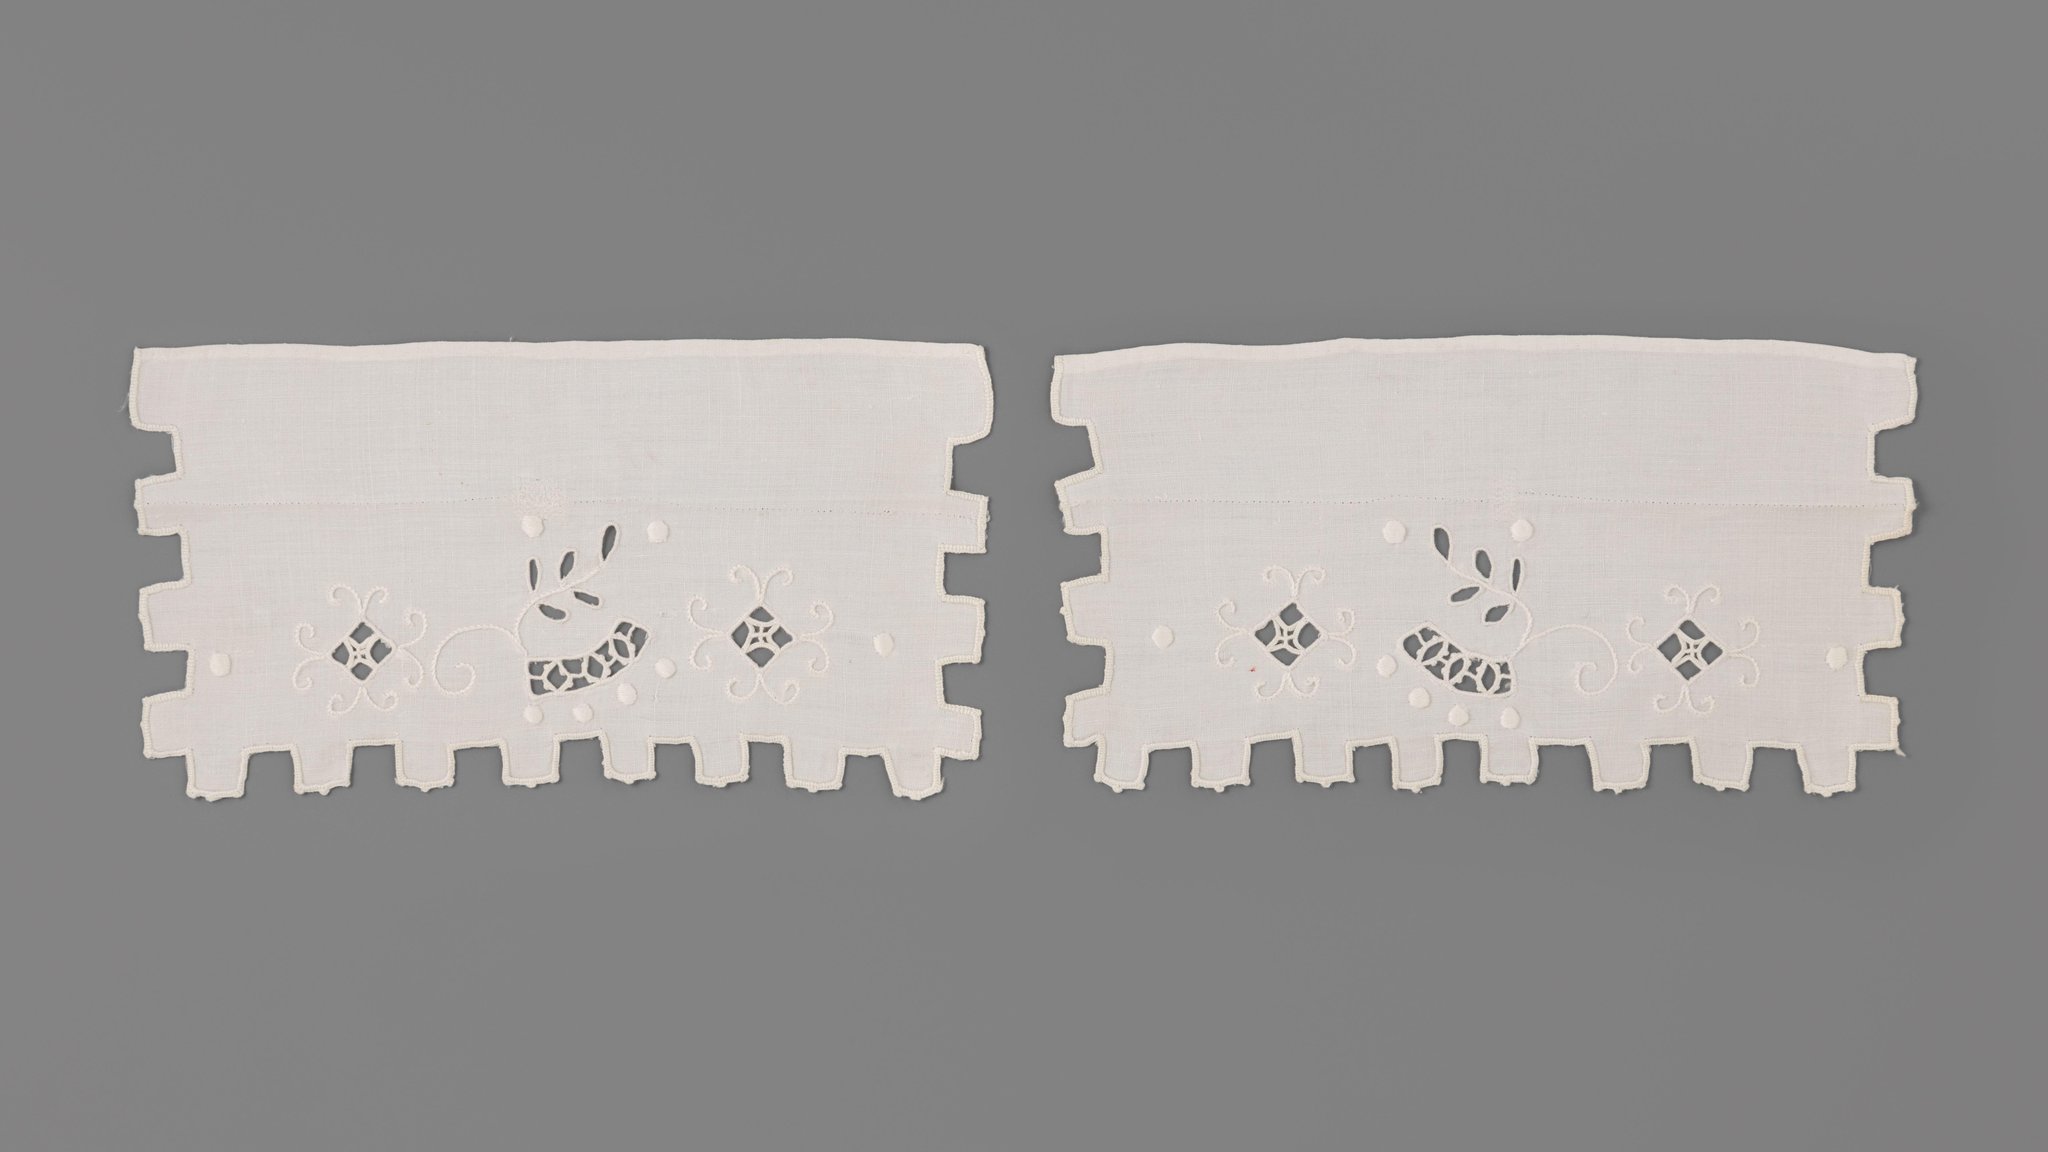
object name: clothing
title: Linnen manchet met dik borduurwerk met open C-vormen en ruiten, omgeven door stippen en hechtranken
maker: Anonymous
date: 1900-1915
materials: linen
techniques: richelieu work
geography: western europe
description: Kraag en manchetten van linnen met richelieu-werk. Model. Kontouren als kantelen aan een shawlkraag en rechthoekigemanchetten. Versiering. Dik borduurwerk met open C-vormen en ruiten. ongeveer door stippen en hechtranken.